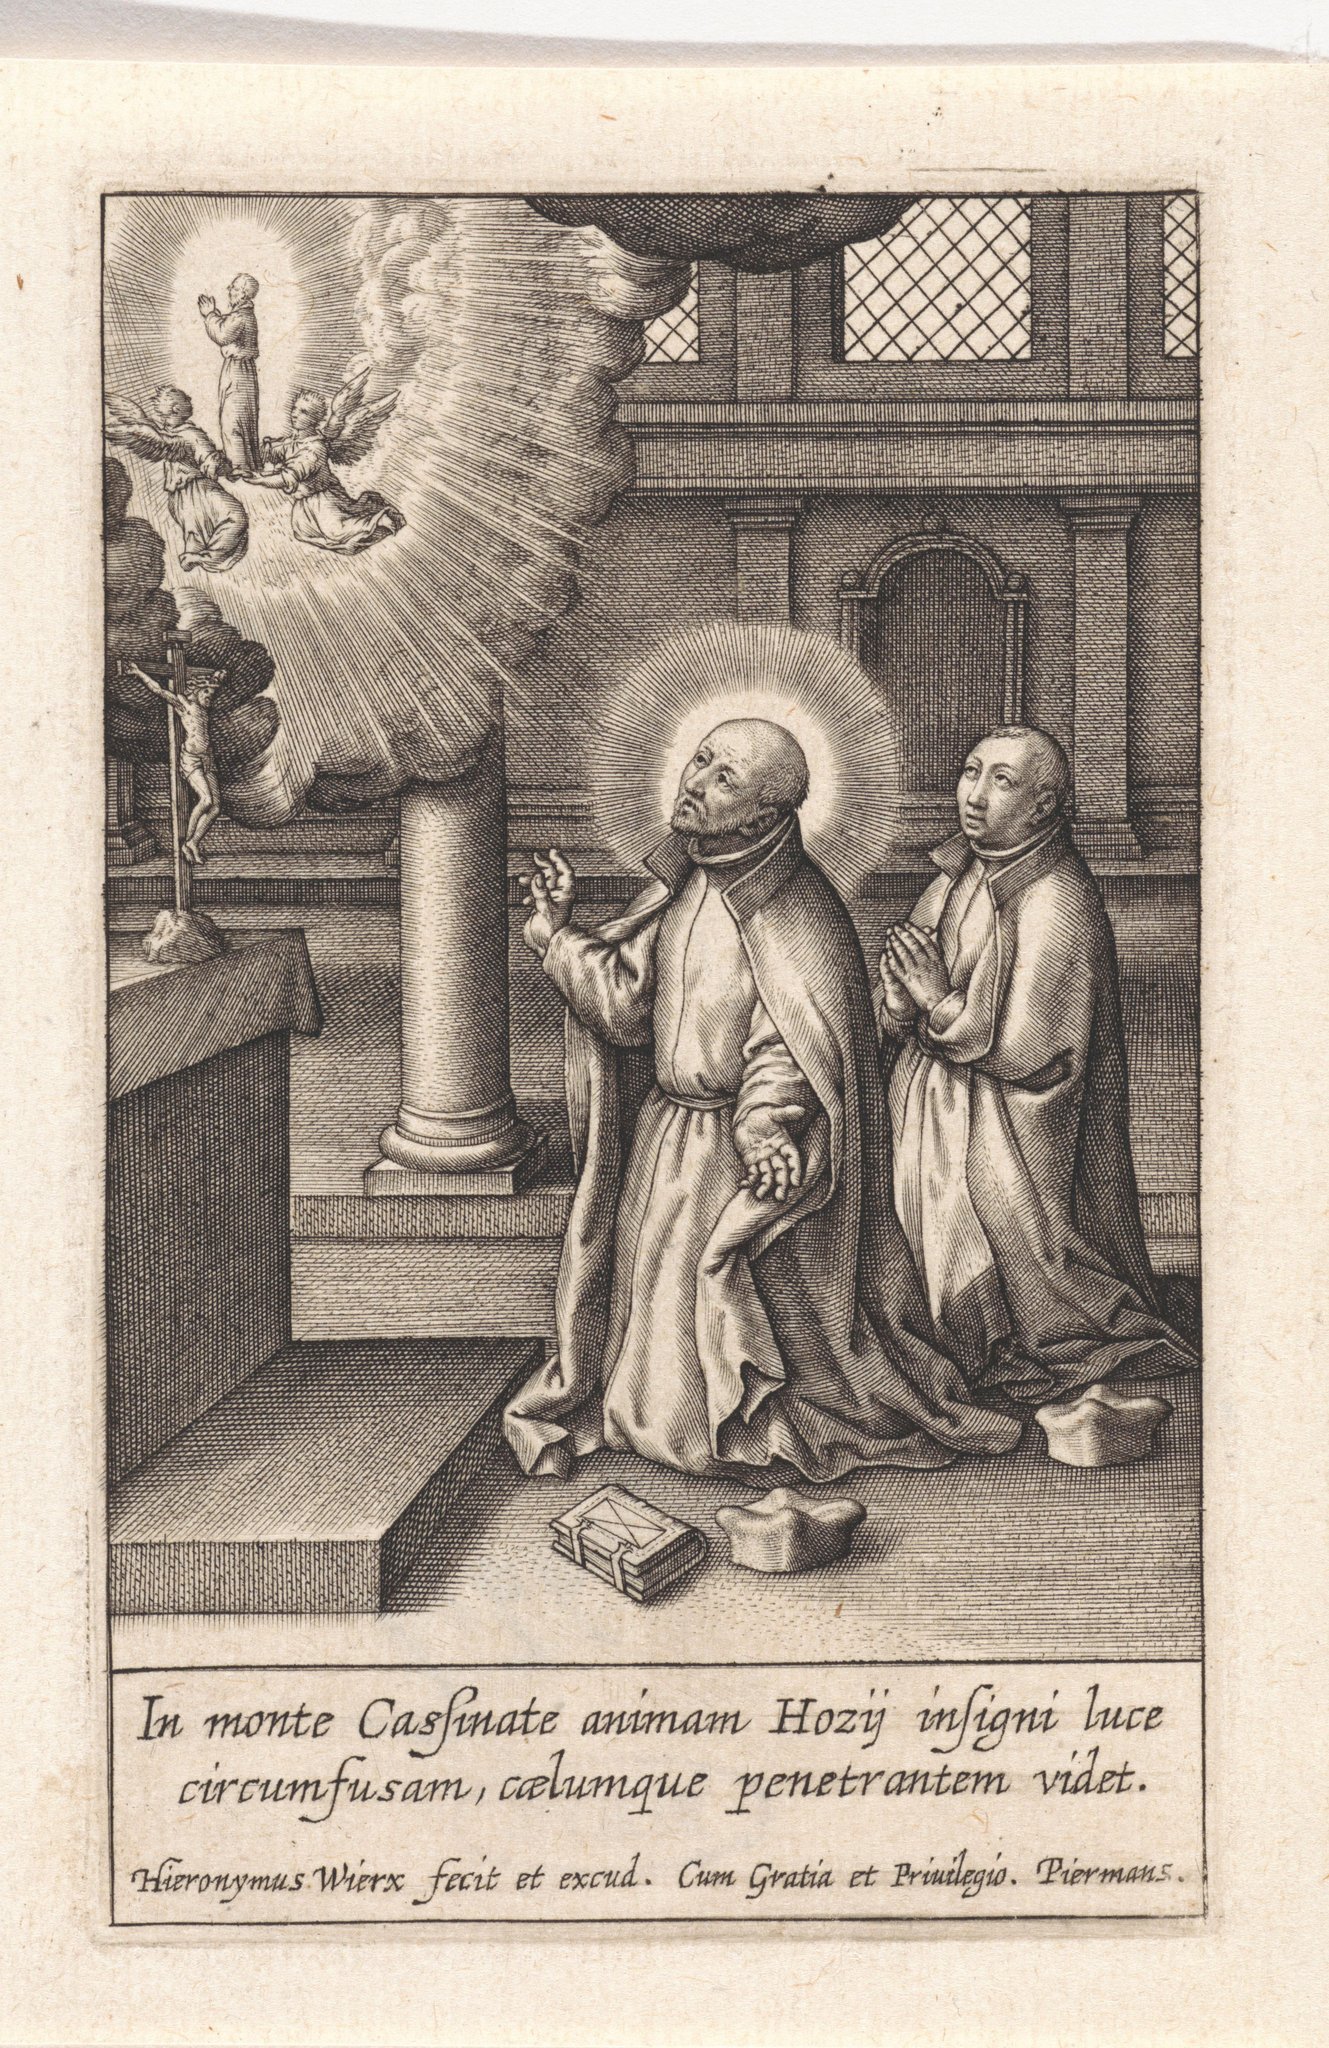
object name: print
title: Leven van Ignatius van Loyola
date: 1611-1615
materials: paper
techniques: engraving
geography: antwerp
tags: visions of st. ignatius of loyola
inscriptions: collector's mark: Lugt 2228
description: Ignatius van Loyola en een andere jezuïet zitten geknield voor een altaar in een kerk. Voor hen een visioen van de ziel van de jezuïet Diego Hoces, die door engelen naar de hemel wordt gevoerd. In de marge een tweeregelig onderschrift in het Latijn.